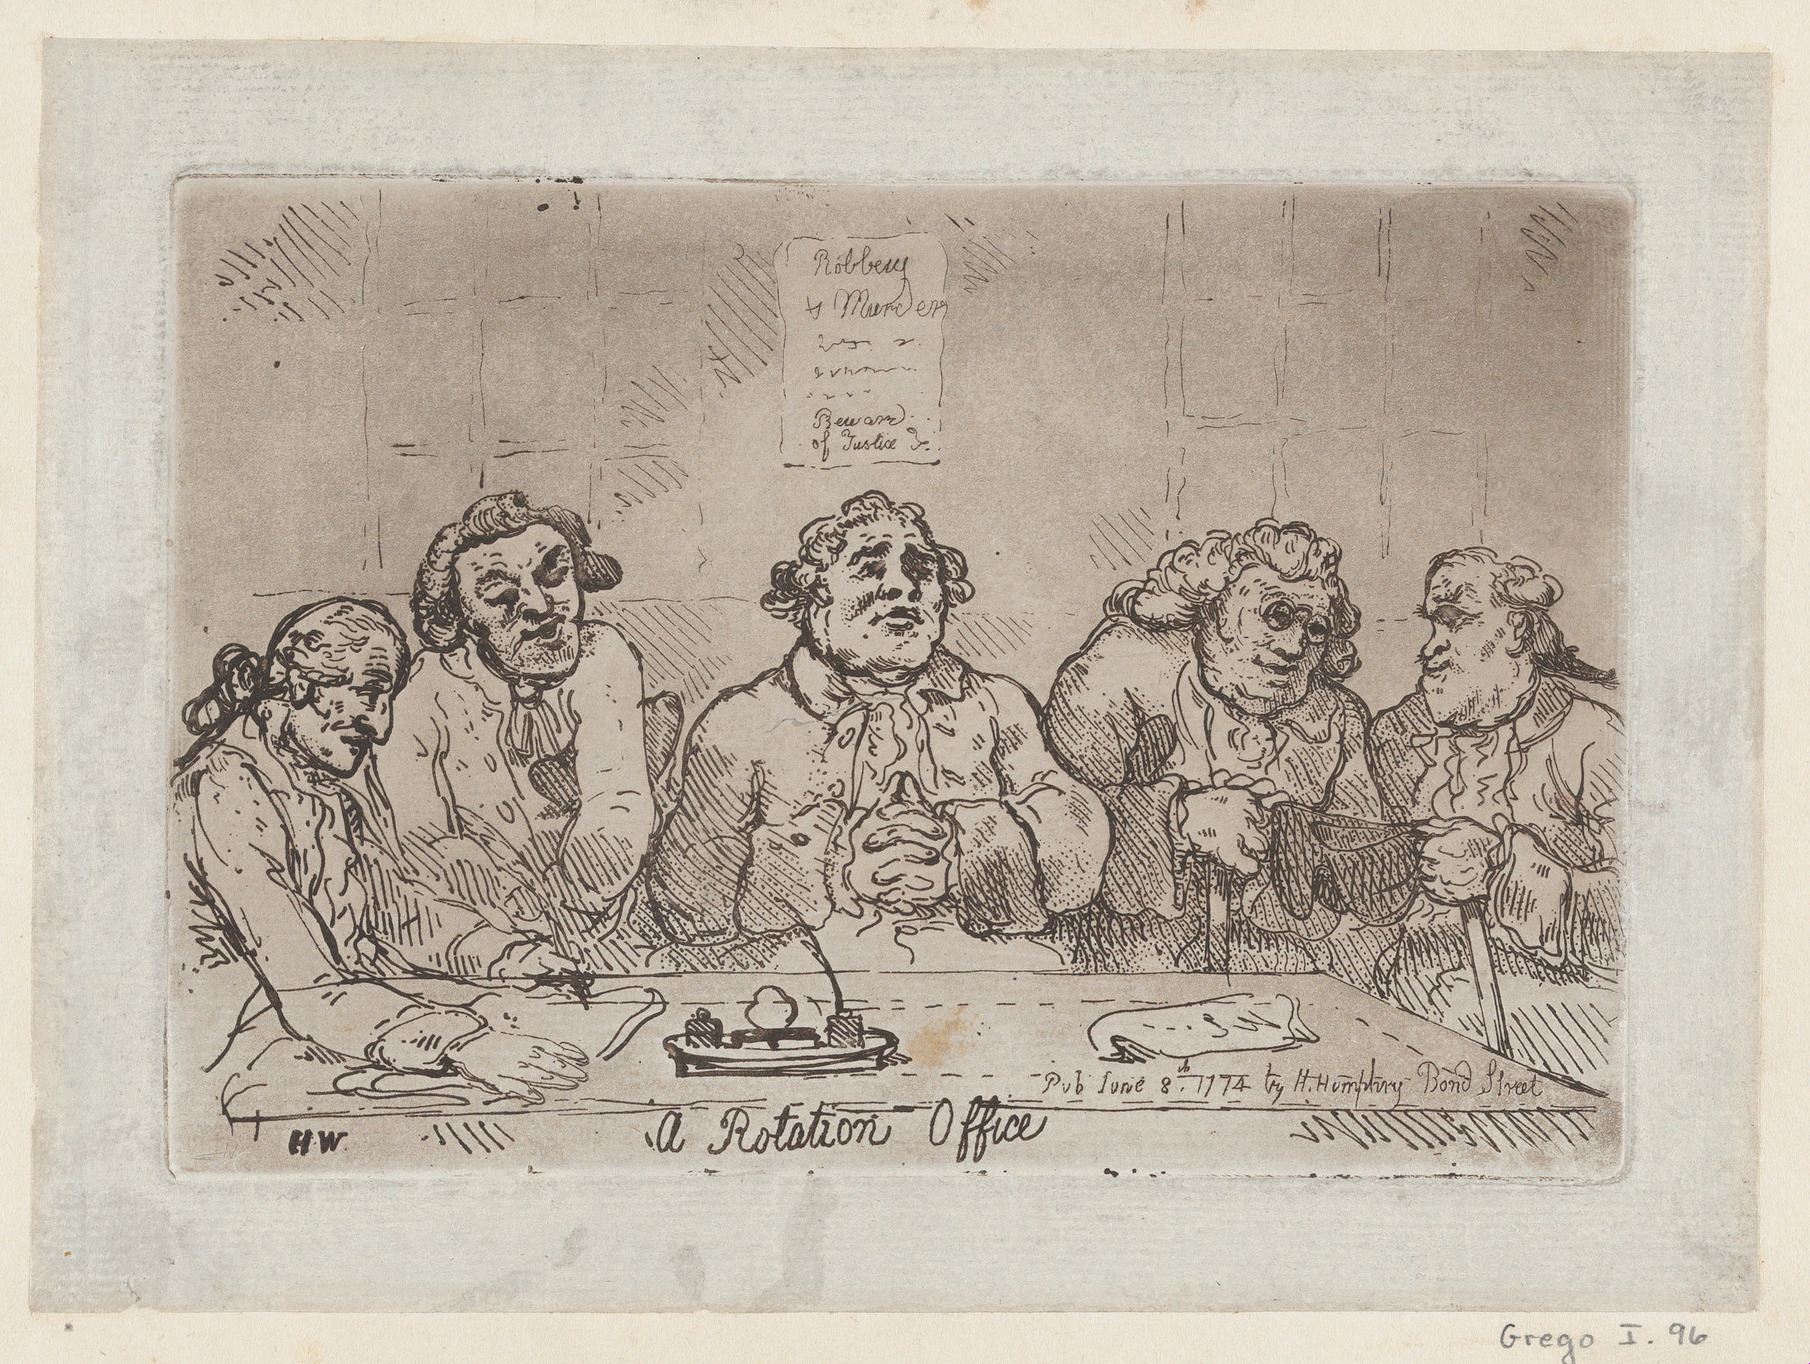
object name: print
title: A Rotation Office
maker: thomas rowlandson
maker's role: artist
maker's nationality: british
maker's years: 1757-1827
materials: ink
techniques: aquatint, etching, printing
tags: satire,men